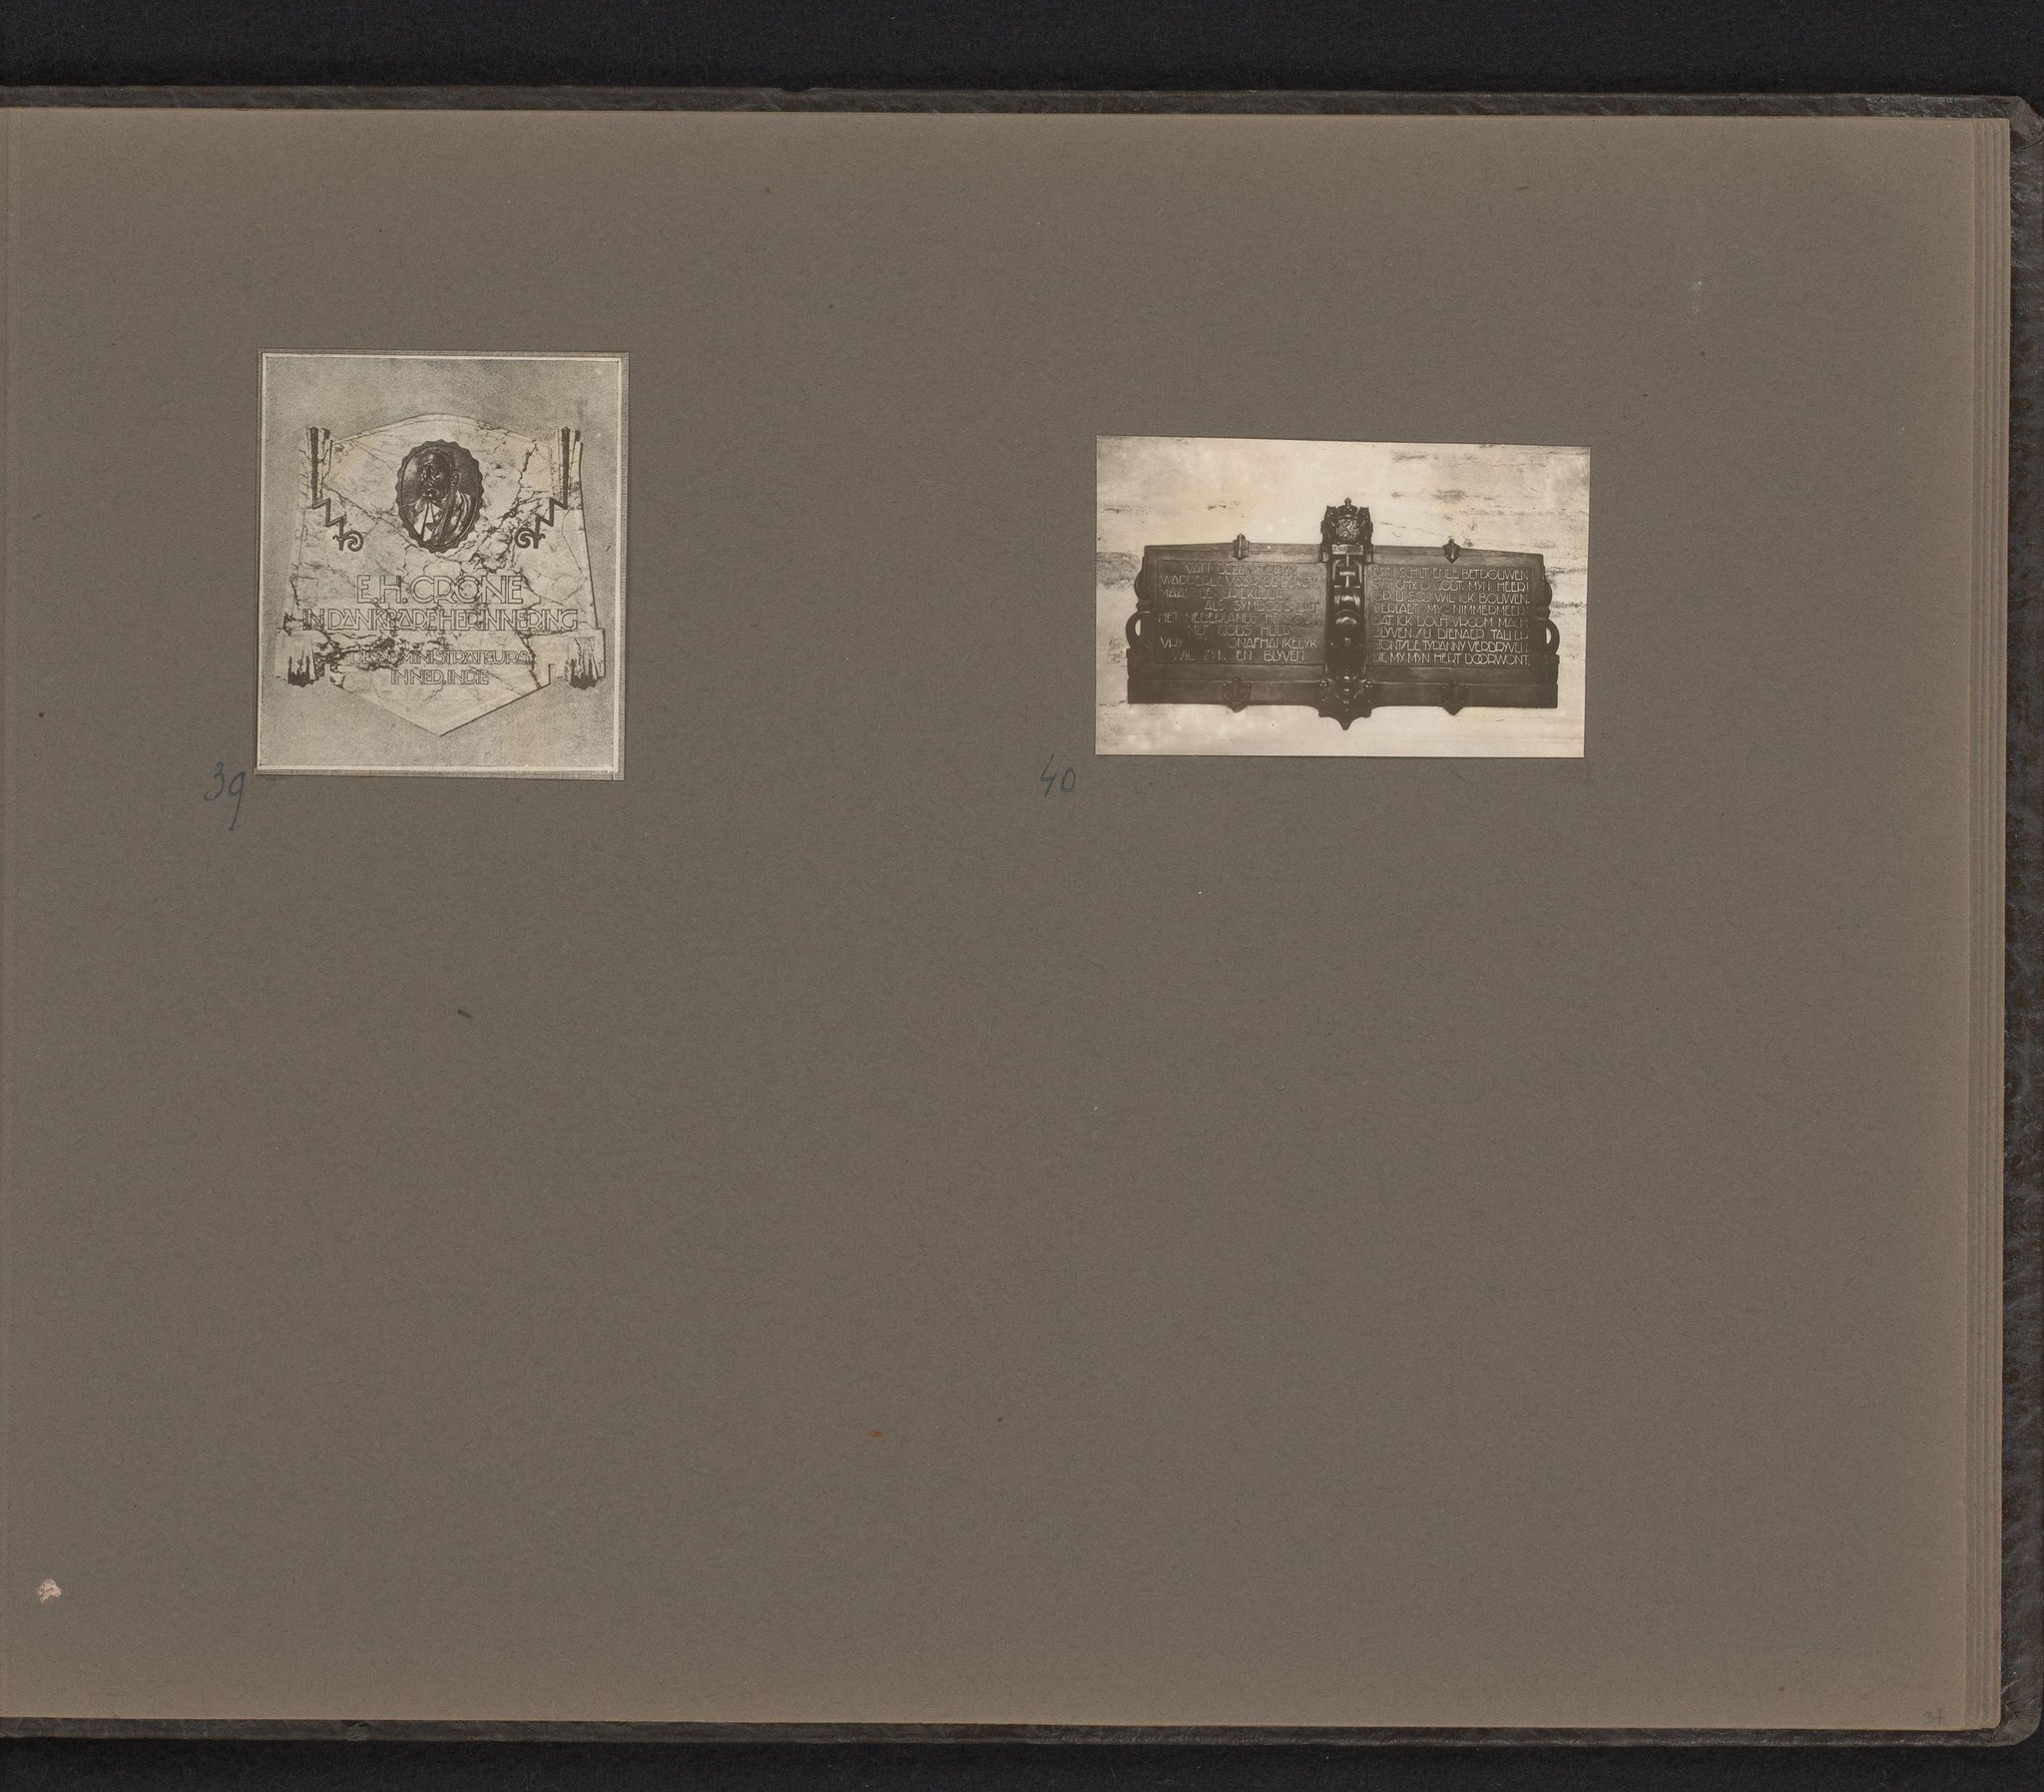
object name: photograph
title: Twee gedenktekens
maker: Anonymous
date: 1920-1940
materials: paper, photographic support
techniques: gelatin silver print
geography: netherlands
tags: other memorial structures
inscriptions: number: ‘39 - 40’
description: Deze foto's maken deel uit van een album.